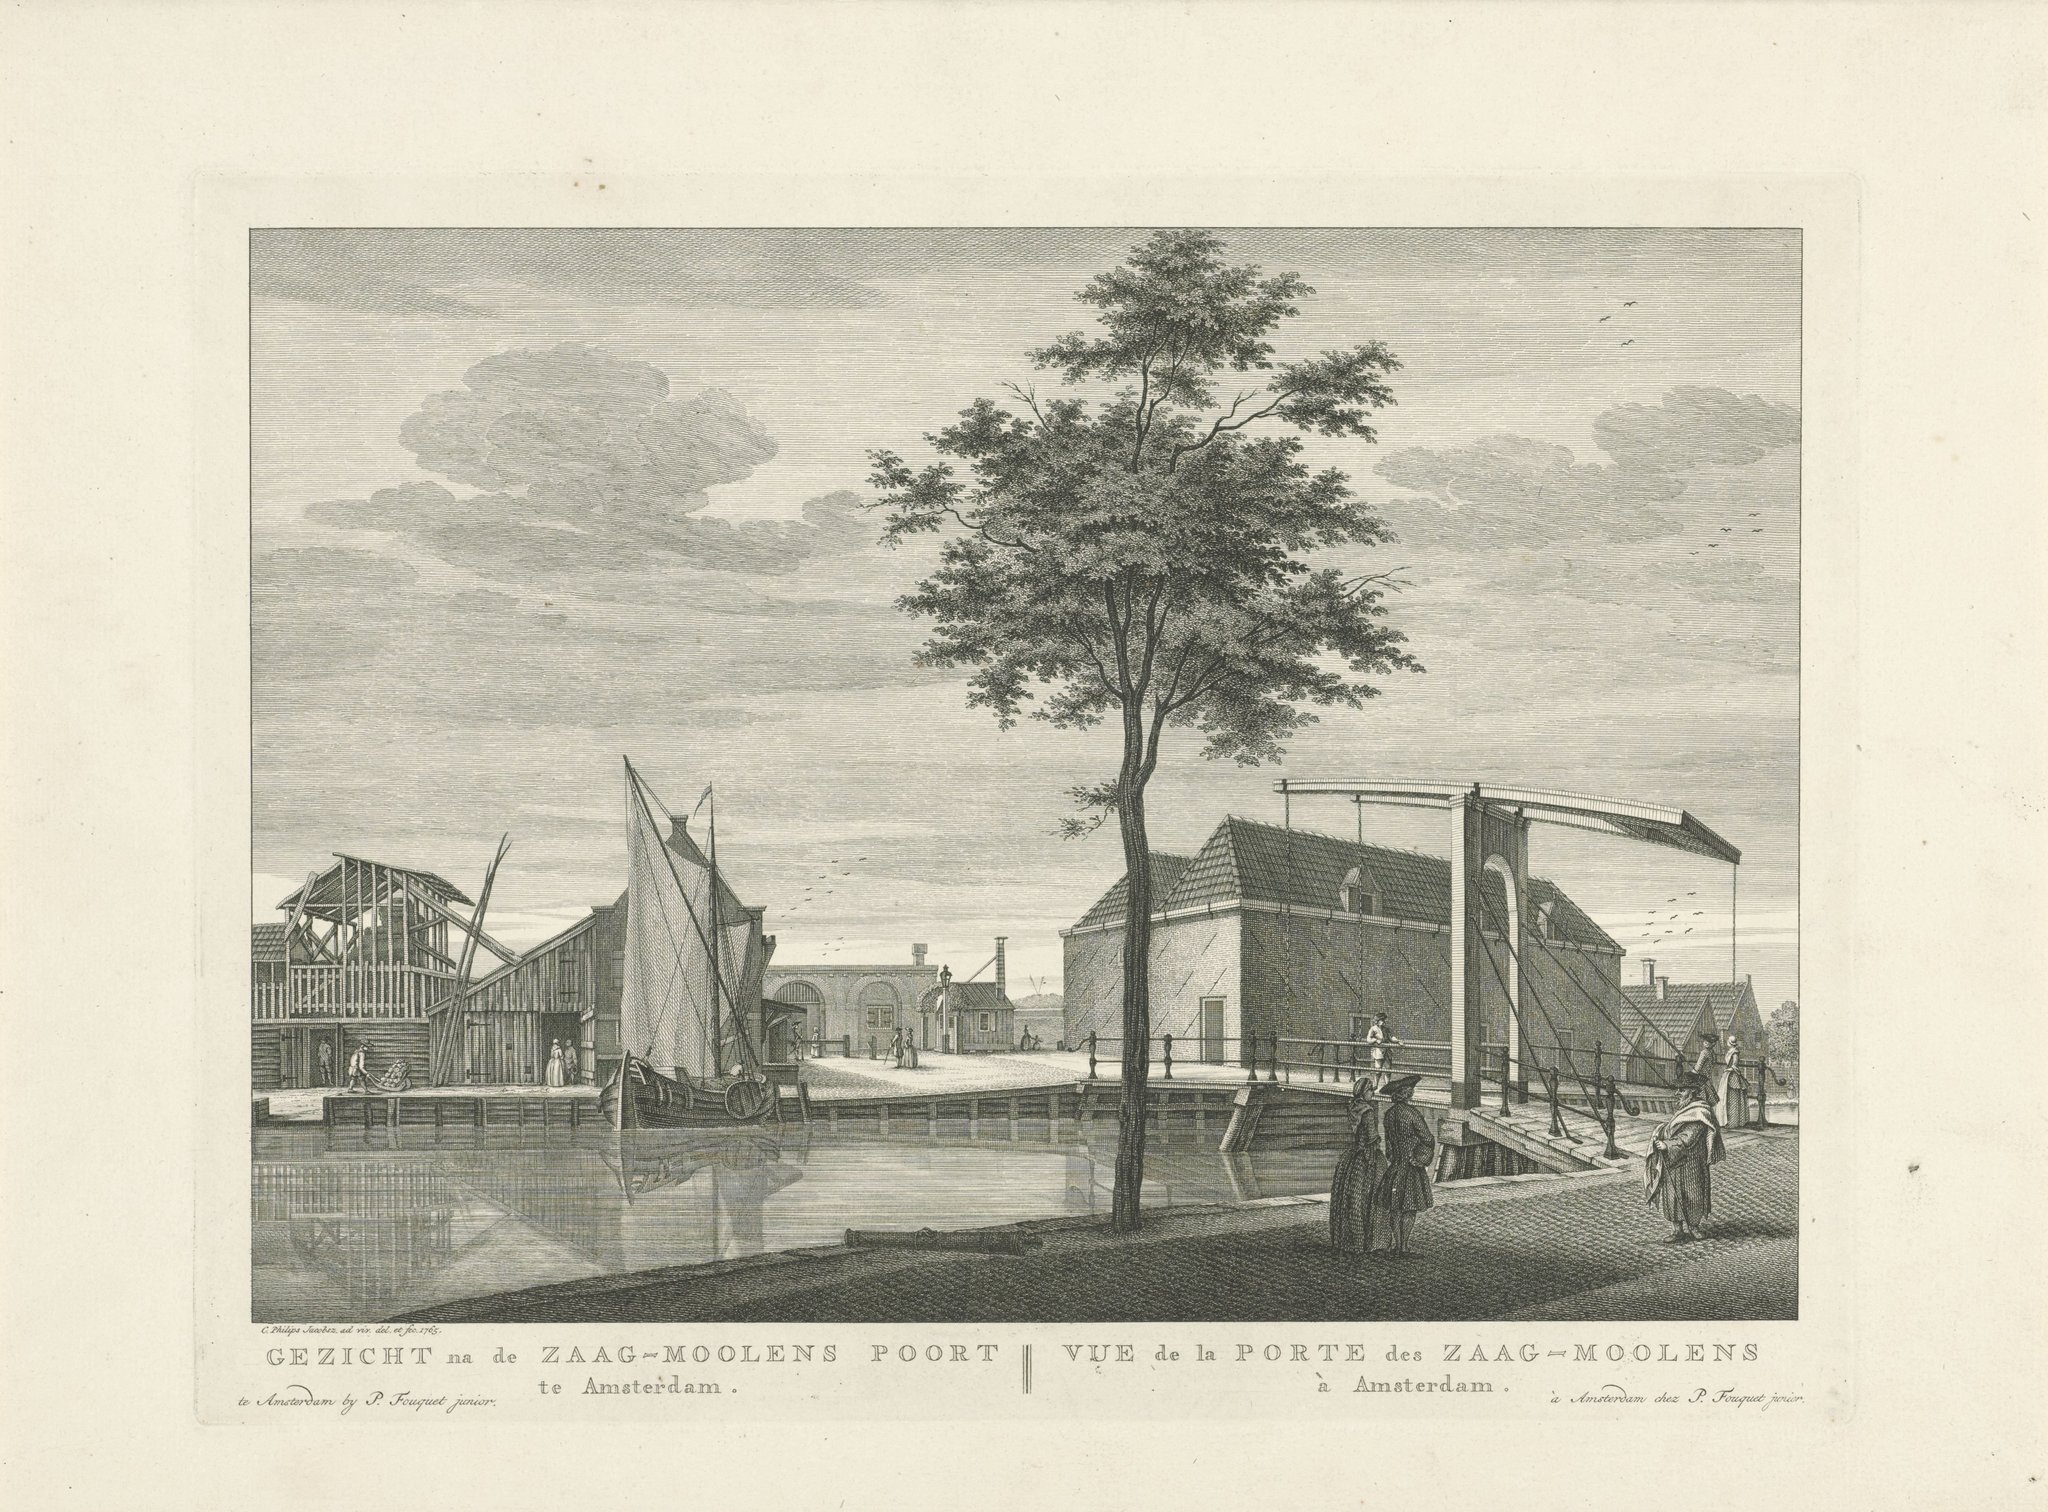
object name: print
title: Gezicht na de Zaag-Moolens Poort te Amsterdam / Vue de la Porte des Zaag-Moolens à Amsterdam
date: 1765-1783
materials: paper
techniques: engraving, etching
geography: amsterdam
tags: bridge in city across river, canal, etc. (+ city(-scape) with figures, staffage), city-gate, canals, waters (in city) (+ city(-scape) with figures, staffage), street (+ city(-scape) with figures, staffage)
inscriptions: collector's mark: Lugt 2228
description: Deze prent is ook gebruikt in de zogenaamde Atlas van Fouquet.* Pierre Fouquet gaf vanaf 1760 stadsgezichten van Amsterdam - naar tekeningen van verschillende kunstenaars, gemaakt door verschillende prentmakers - uit. Deze prenten werden aanvankelijk los of in series verkocht. Zoals toen gebruikelijk kon de koper de prenten zelf laten inbinden. Hiertoe gaf Fouquet tussen 1778 en 1783 een titelblad, plattegrond en inhoudsopgave van de tot dusver 100 uitgegeven prenten uit (1). Gezien de inhoud afhankelijk was van wat de koper had verzameld verschilt de inhoud van de verschillende bewaarde Fouquetatlassen onder deze titel sterk. Ook zijn er exemplaren bekend waar tevens andere prenten aan zijn toegevoegd. Omdat er behoefte bleek aan uitleg bij de platen werd in 1783 een nieuwe versie van de atlas uitgegeven, aangevuld met tekst en twee prenten. De aangegeven volgorde veranderde maar de platen van de al eerder uitgegeven prenten bleven ongewijzigd. Deze uitgave werd in opdracht van Fouquet gedrukt bij Daniël Jean Changuion en Petrus den Hengst (2). Een tiental platen werd bijgewerkt en verscheen, met nieuw impressum, in het vervolg van Wagenaars geschiedenis van Amsterdam, uitgeven door Petrus Conradi en Folkert van der Plaats (3). Een aantal jaar na het overlijden van Fouquet kwam Evert Maaskamp met een nieuwe uitgave van de atlas, met verbeterde tekst en toevoeging van twee prenten. Op alle platen verwijderde hij het oude en liet hij zijn eigen impressum zetten (4). De huidige staat van de prent komt voor in exemplaren van de onder (1) en (2) genoemde werken. * Onder de Atlas van Fouquet of Fouquetatlas verstaan we de hieronder vermelde publicaties (1), (2) en (4). (1). Afbeeldingen van de wyd-vermaarde koopstad Amsterdam benevens des zelvs voornaamste gebouwen en gezigten alle naar het leeven getekend / Receuil des edifices les plus considerables et des plus belles vues, de la fameuse ville d'Amsterdam, dessinées d'après nature. Amsterdam: Pierre Fouquet, 1778-1783. (2). Nieuwe atlas, van de voornaamste gebouwen en gezigten der stad Amsterdam, met derzelver beknopte beschryvingen. 2 delen. Amsterdam: Daniël Jean Changuion en Petrus den Hengst [in opdracht van Pierre Fouquet], 1783. (3). Stijl, Simon. Amsterdam, in zyne geschiedenissen, voorregten, koophandel, gebouwen, kerkenstaat, schoolen, schutterye, gilden en regeeringe, beschreeven. Om te dienen ten vervolge op het werk van Jan Wagenaar (…). 10 delen. Amsterdam en Harlingen: Petrus Conradi en Folkert van der Plaats, 1788-1801. (4). Nieuwe atlas, van de voornaamste gebouwen en gezigten der stad Amsterdam. Met derzelver beknopte beschryvingen. Amsterdam: Evert Maaskamp, 1805. * Het aantal vermelde staten is gebaseerd op het aantal gevonden staten. Mogelijk zijn er meer staten van deze prent. Voor tweede bekende staat zie RP-P-AO-27-7A.